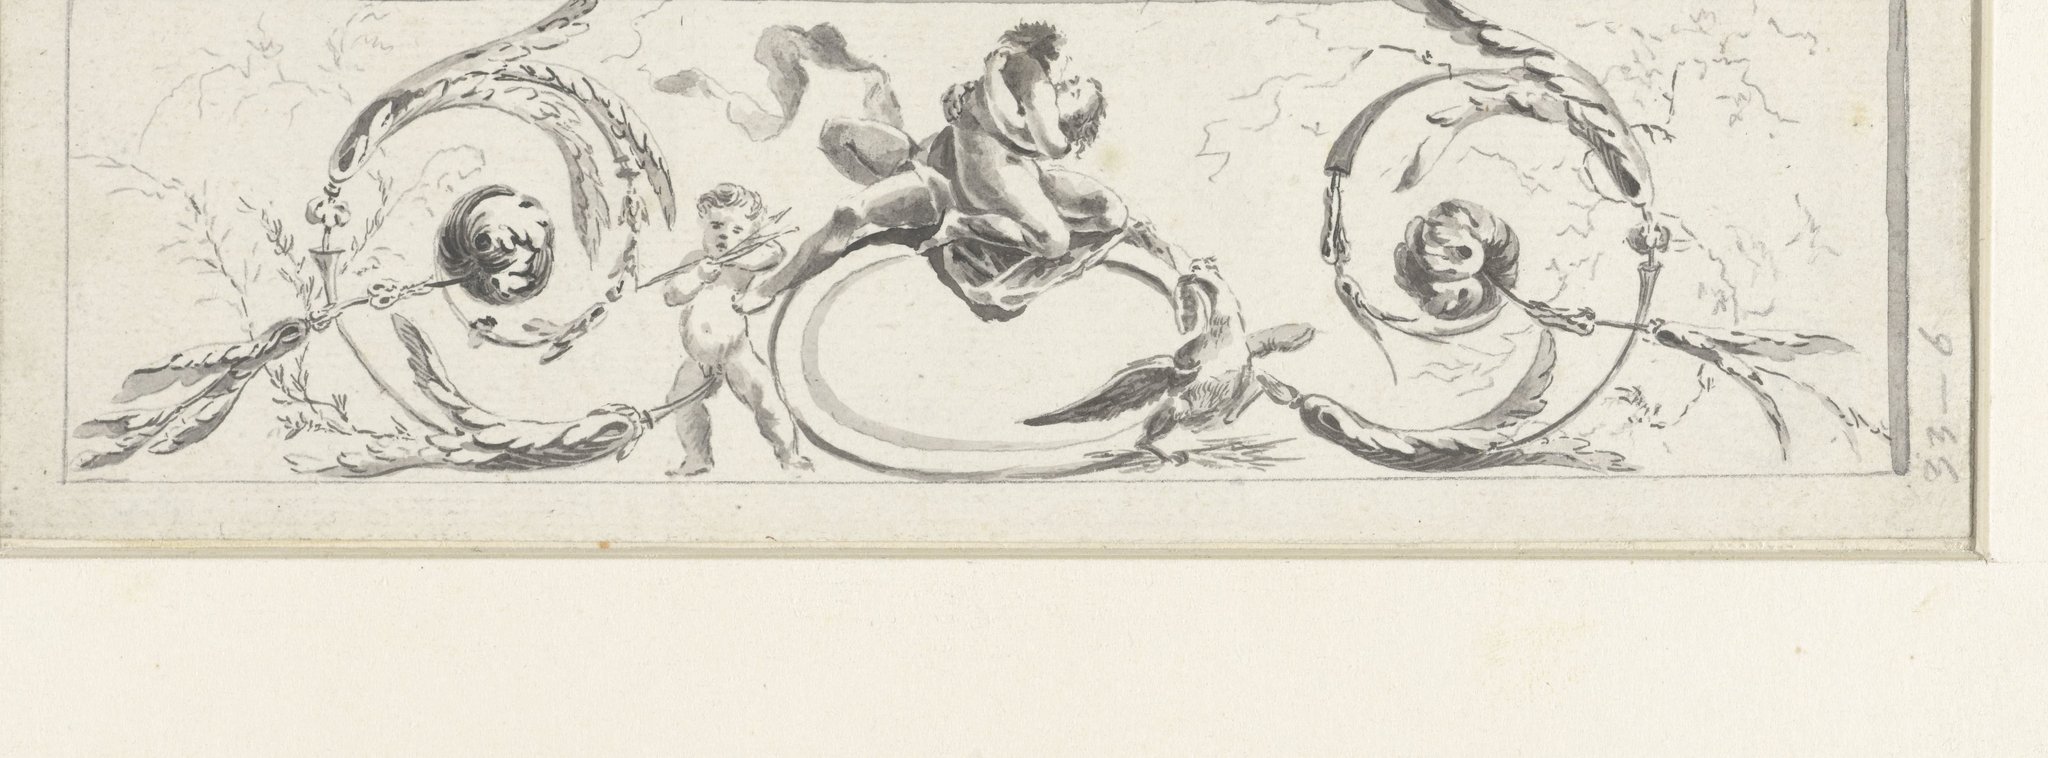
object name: ornamenttekening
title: Fries, samengesteld uit acanthus-ranken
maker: henri sallembier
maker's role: draughtsman, painter, print maker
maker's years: 1753-1820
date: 1763-1820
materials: ink, paper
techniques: brush, pen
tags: (lovers) embracing each other, 'symplegma', foliage, tendrils, branches ~ ornament, cupids: 'amores', 'amoretti', 'putti'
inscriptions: annotation, pencil: ‘Marot [?]’, collector's mark: Lugt 581